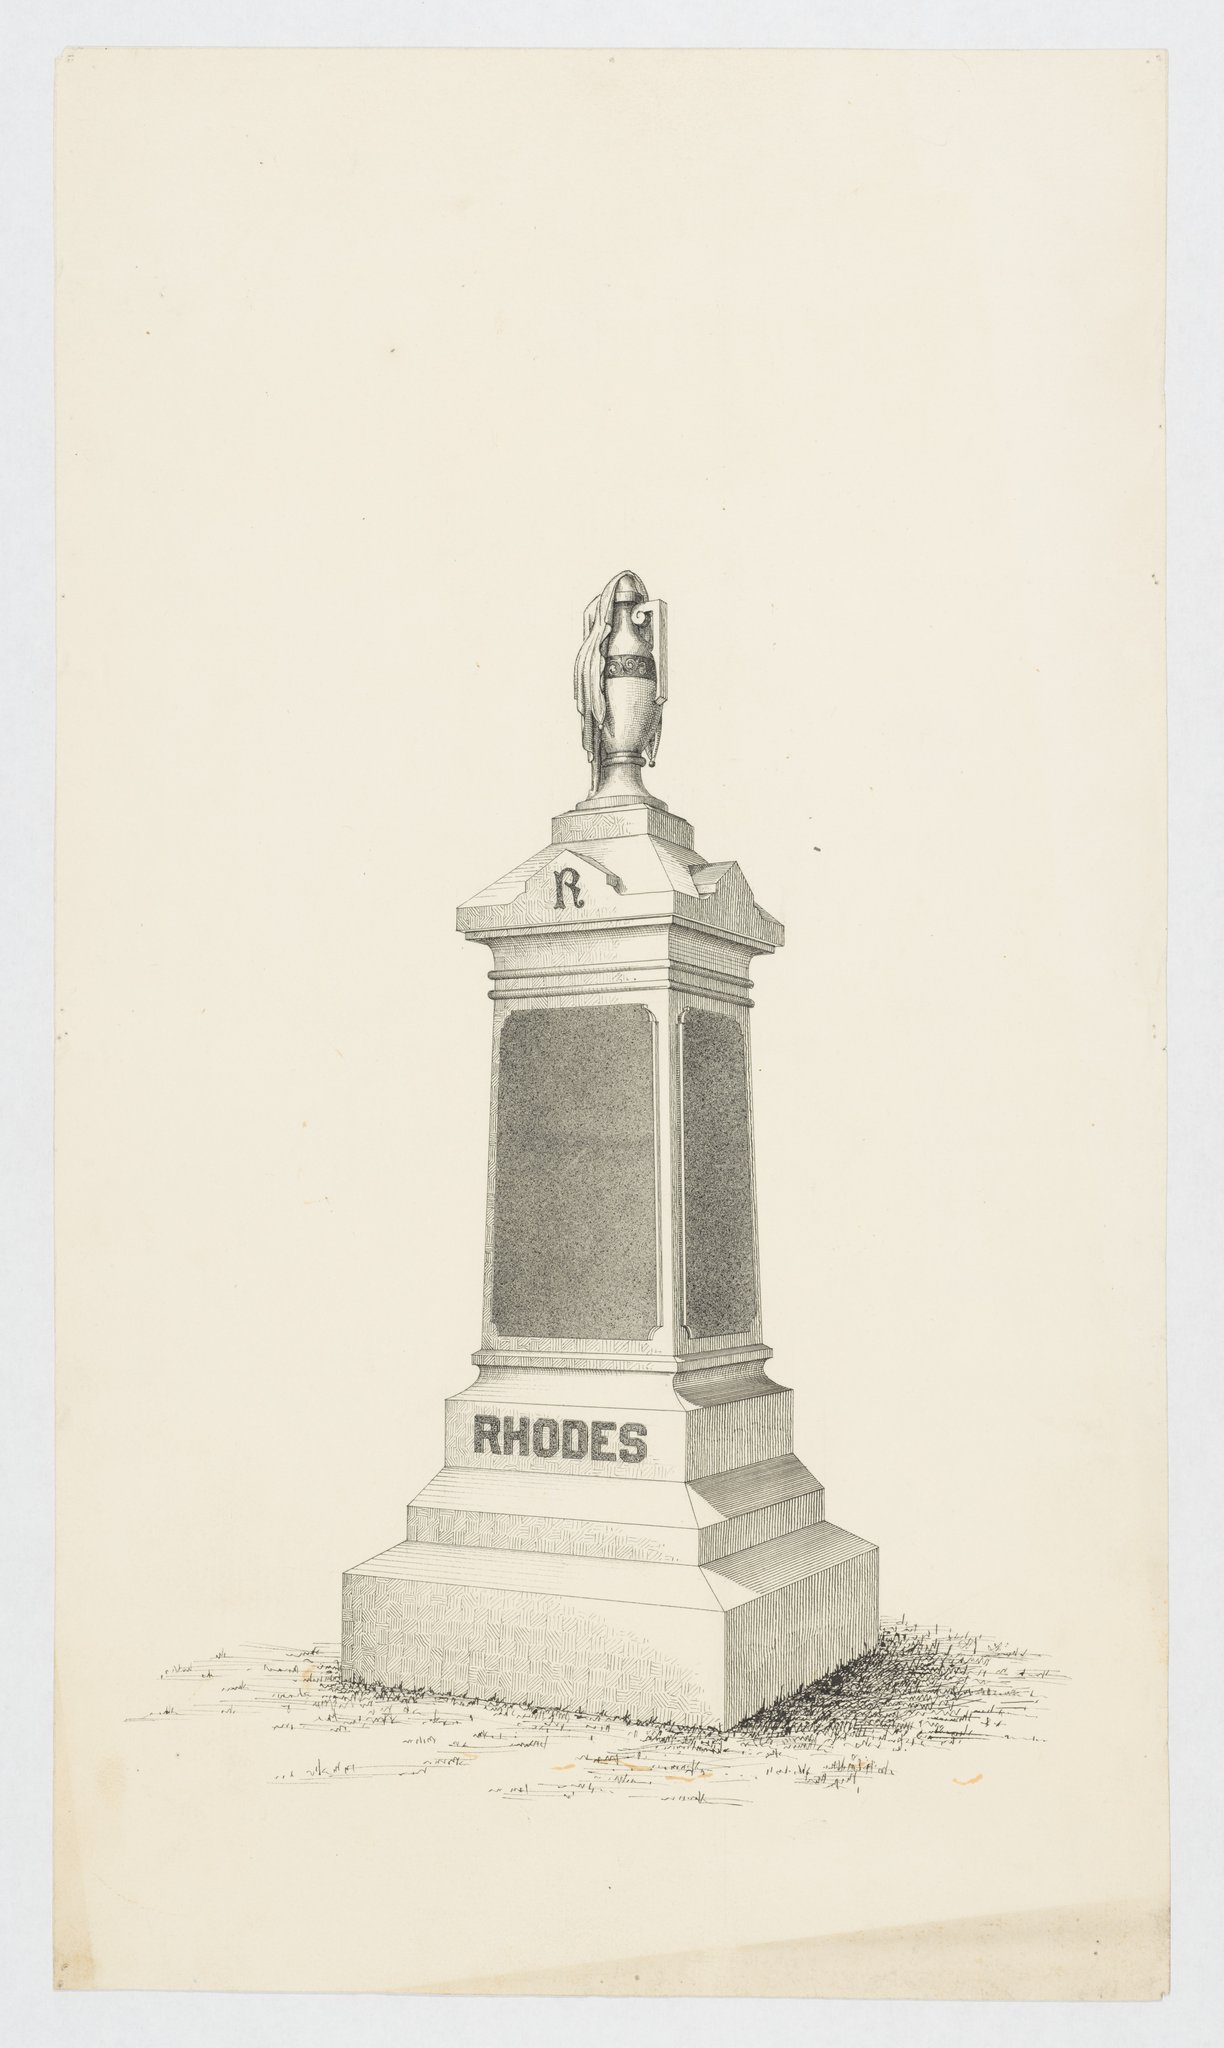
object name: drawing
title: Grave Monument with Vase, for "Rhodes" (recto); Scaffolding and pulley systems (verso)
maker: alexander maxwell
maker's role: artist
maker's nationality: american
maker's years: 1838-1880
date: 1840-1880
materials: graphite, ink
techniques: wash